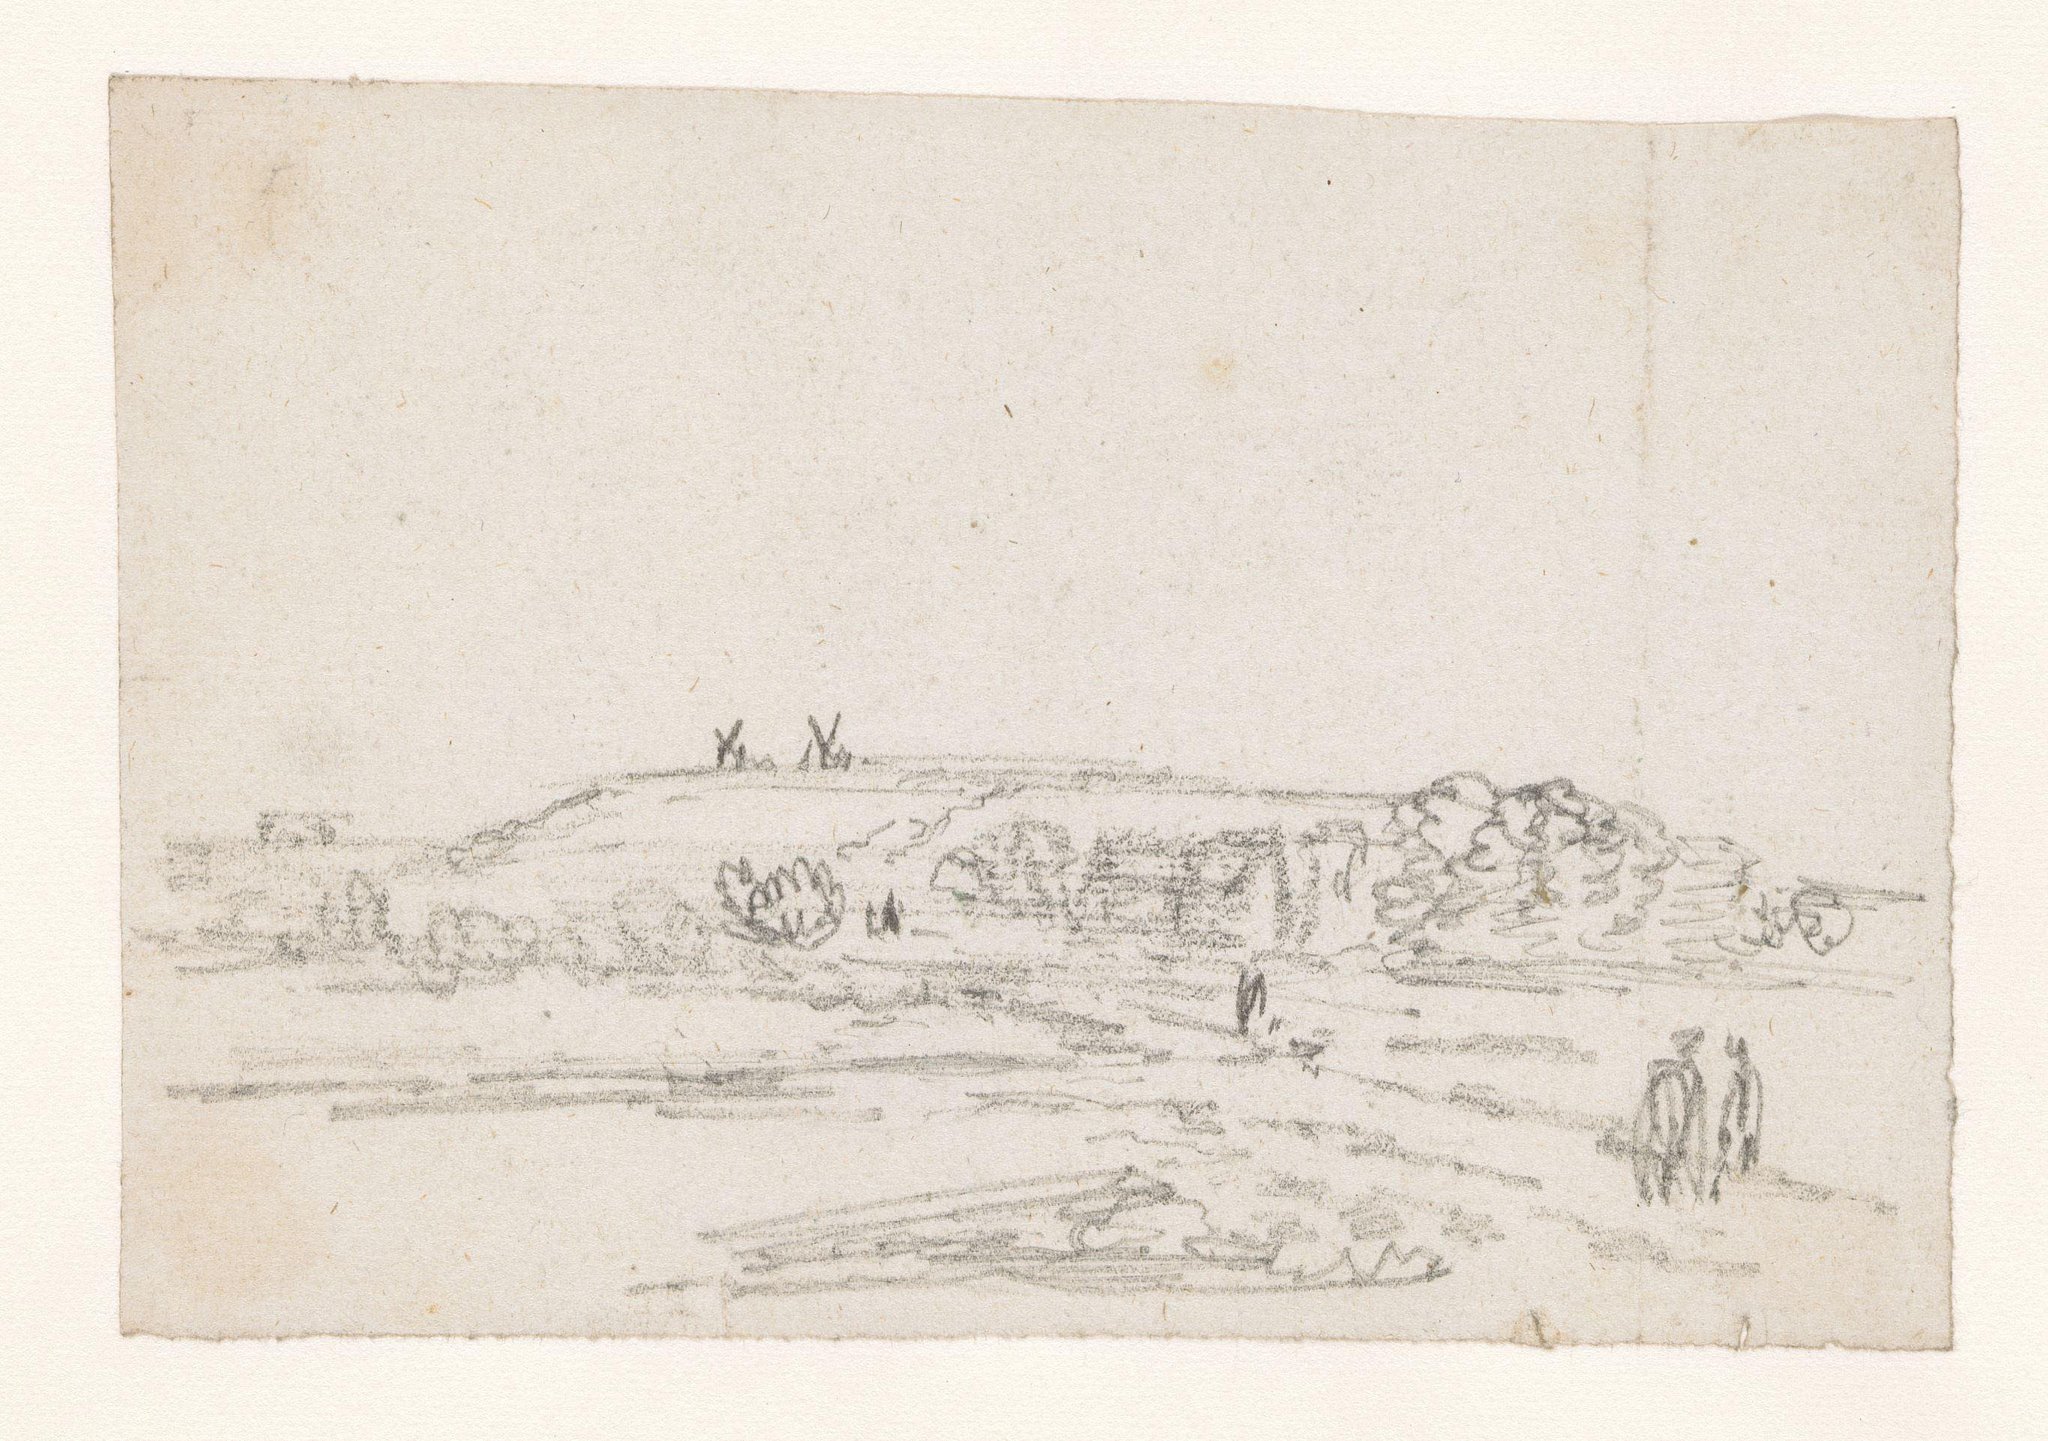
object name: drawing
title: Gezicht op een heuvel, waarop twee molens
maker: georges michel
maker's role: draughtsman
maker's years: 1763-1843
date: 1773-1843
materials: paper, pencil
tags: windmill in landscape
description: Een van 120 tekeningen, afkomstig uit een 19e eeuws album met tekeningen van Georges Michel.